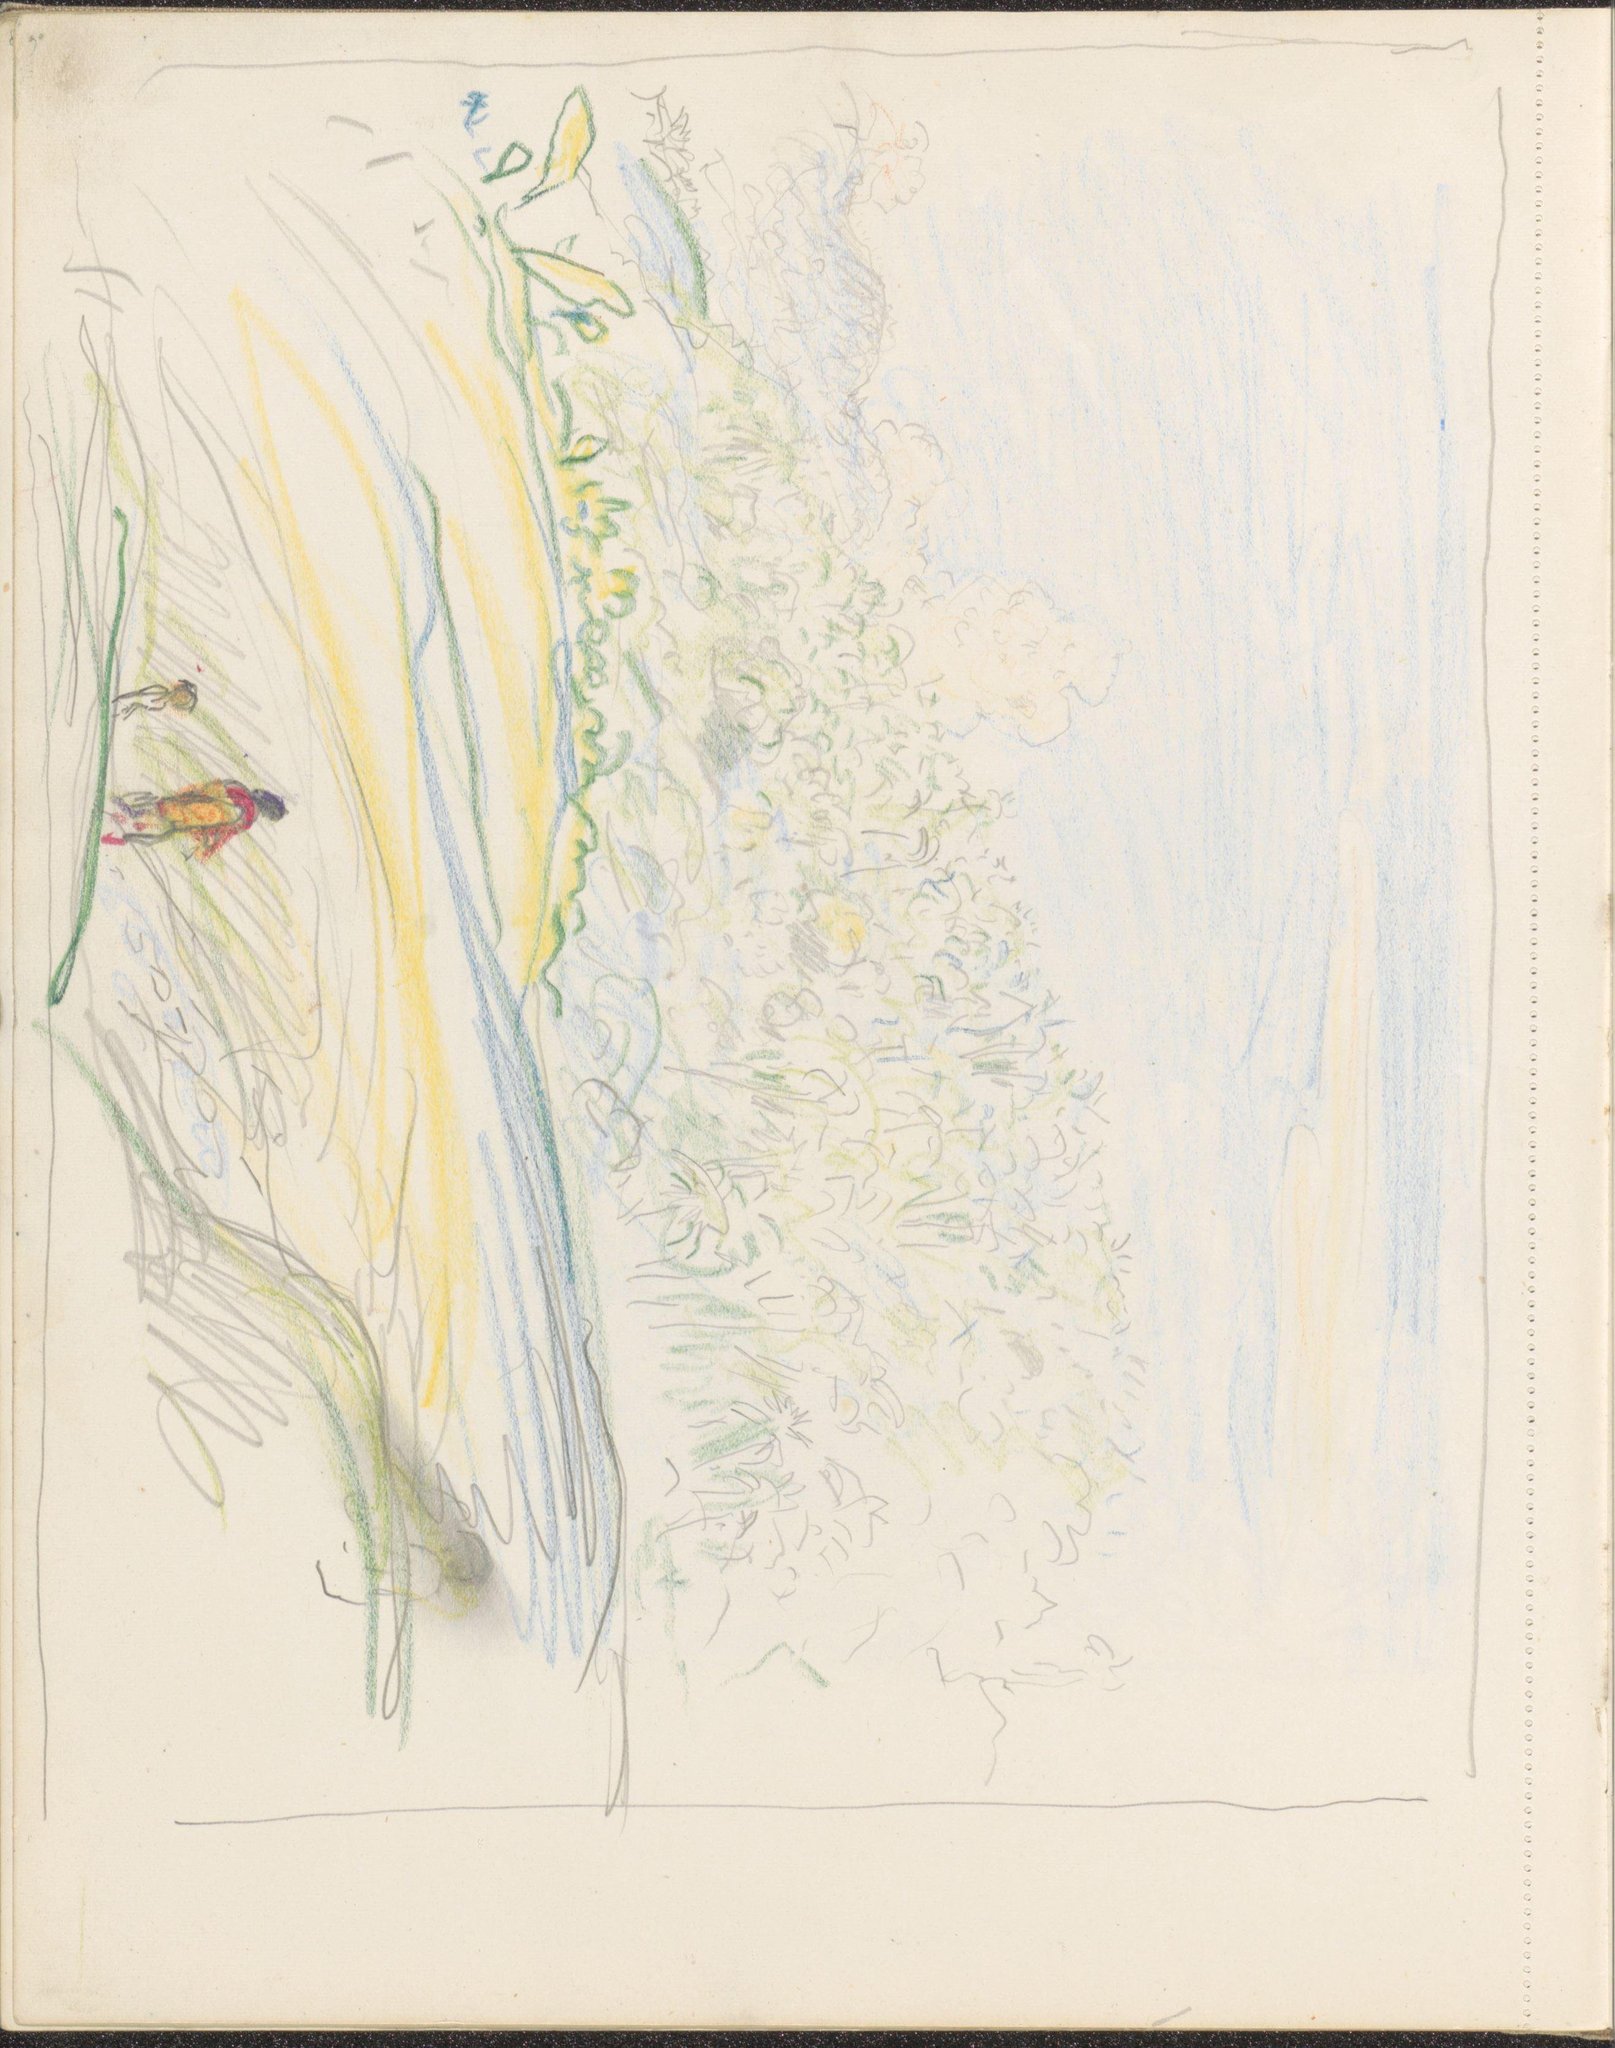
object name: sketchbook leaf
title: Twee figuren in een boomrijk heuvellandschap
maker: marius bauer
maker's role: draughtsman, print maker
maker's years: 1867-1932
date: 1931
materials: chalk, paper, pencil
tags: low hill country, trees, landscapes (+ landscape with figures, staffage)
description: Pagina 90 uit een schetsboek met 48 bladen.